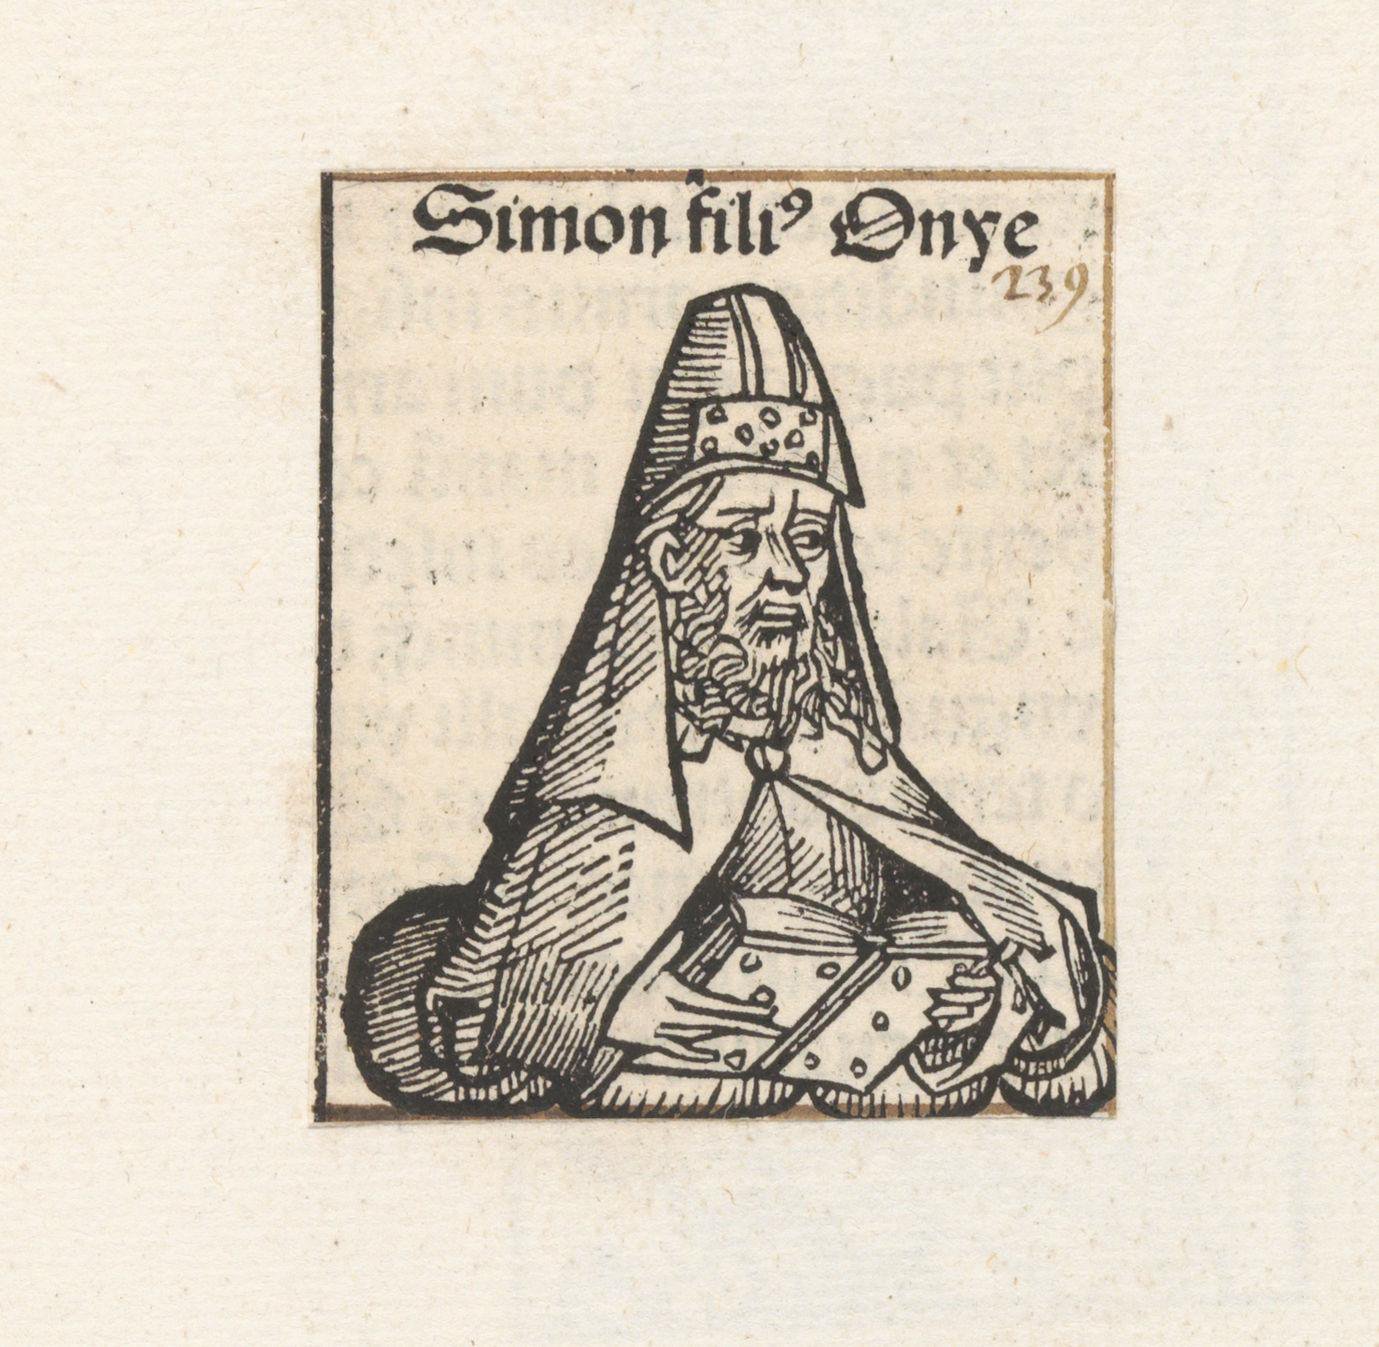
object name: print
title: Simon I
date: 1493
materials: paper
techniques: letterpress printing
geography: nuremberg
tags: reading, high priest ~ hierarchy of priests, persons from the old testament (not in biblical context, nor occurring in legendary/historical extensions included in division 71)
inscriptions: inscription: ‘239’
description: Een bloemkelk met een man in priesterkledij, naar rechts gekeerd. Hij heeft een boek in zijn handen. De tekst identificeert hem als Simon, hogepriester. Mogelijk betreft het Simon I, zoon van Onias I. De voorstelling is onderdeel van de opeenvolging priesters in de Liber Chronicarum. De prent maakt deel uit van een album.